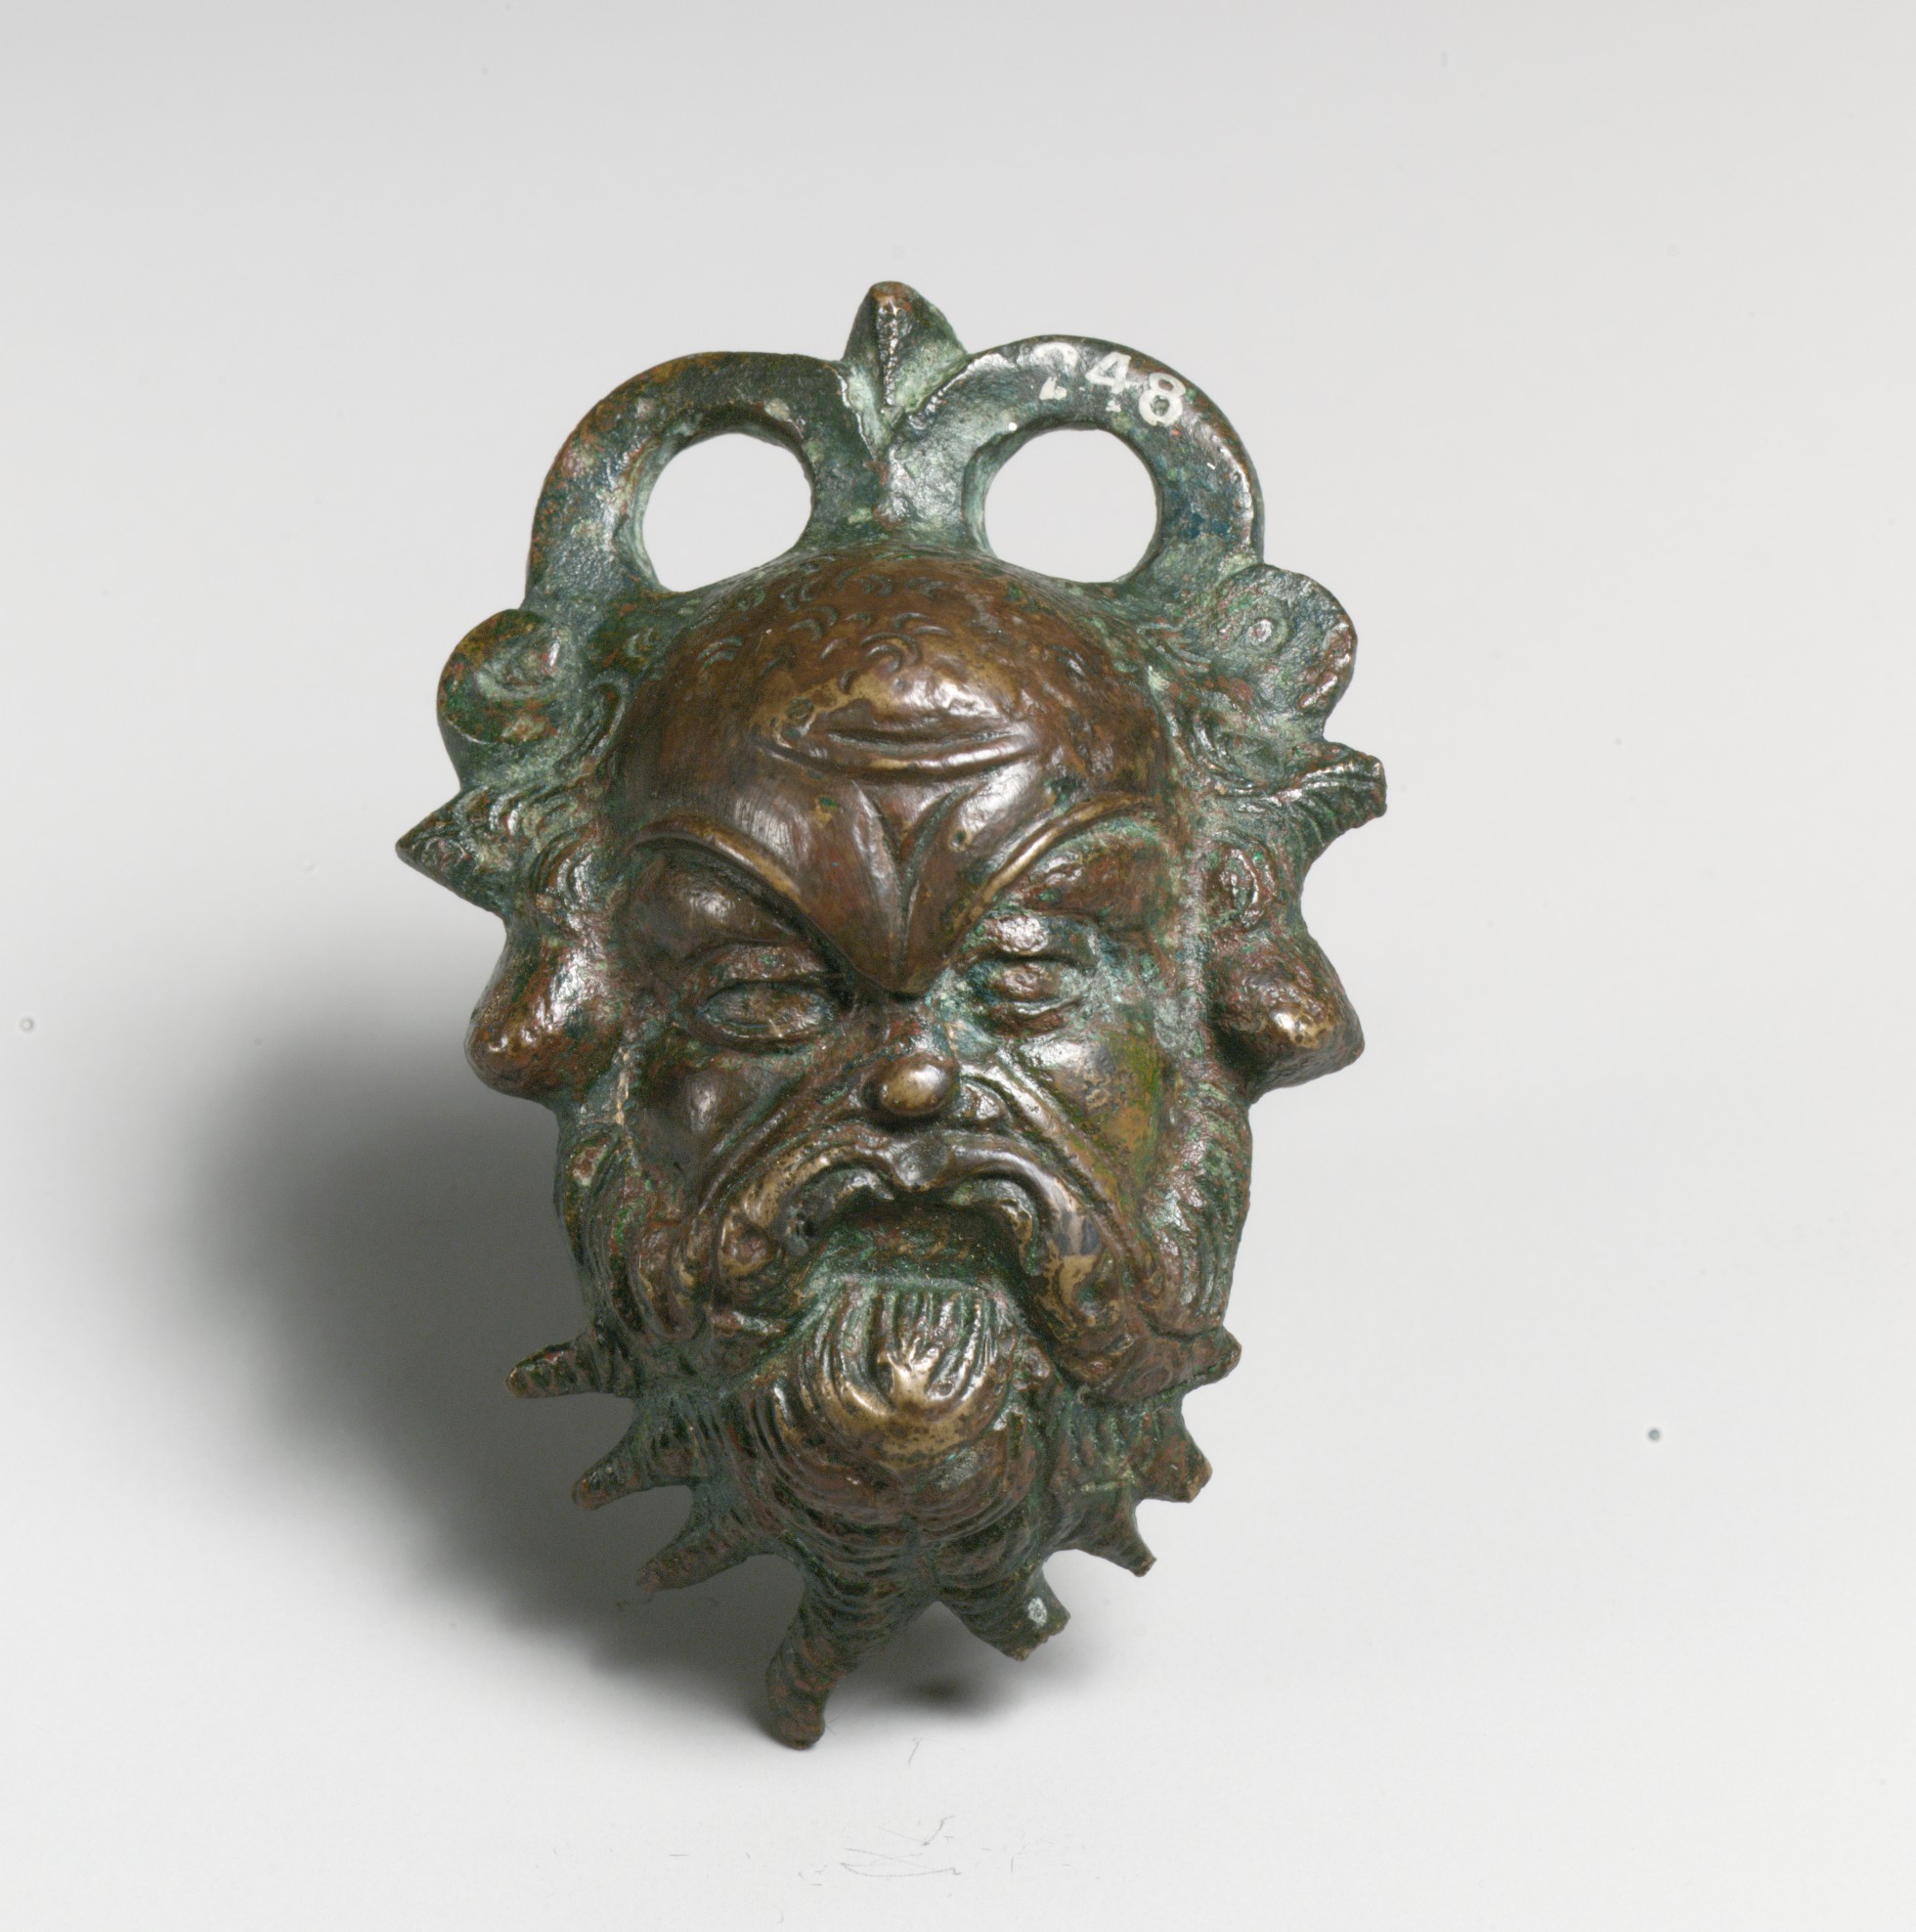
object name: head of silenos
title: Bronze situla (pail) attachment in the form of a Silenos head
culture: greek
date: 400-301 BCE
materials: bronze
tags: silenus